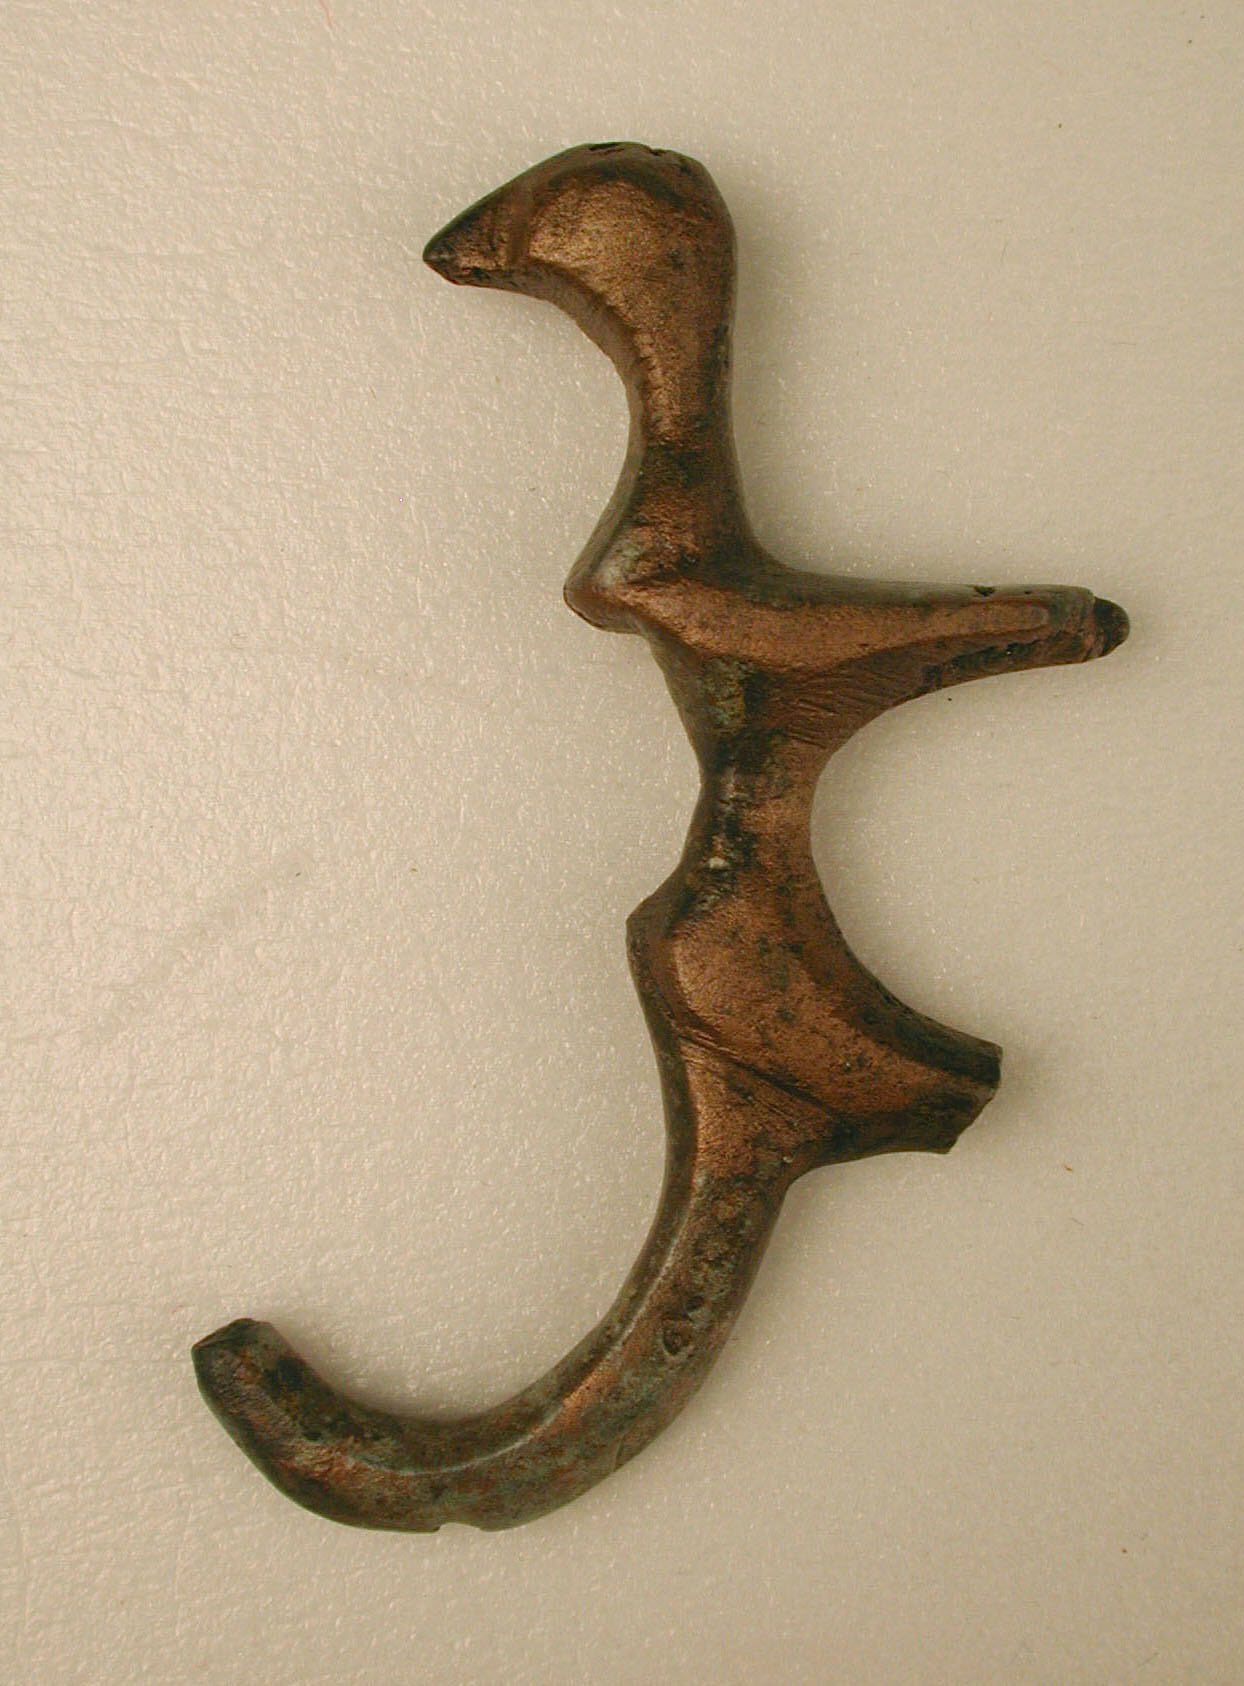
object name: hook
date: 801-1000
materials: bronze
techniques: casting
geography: iran